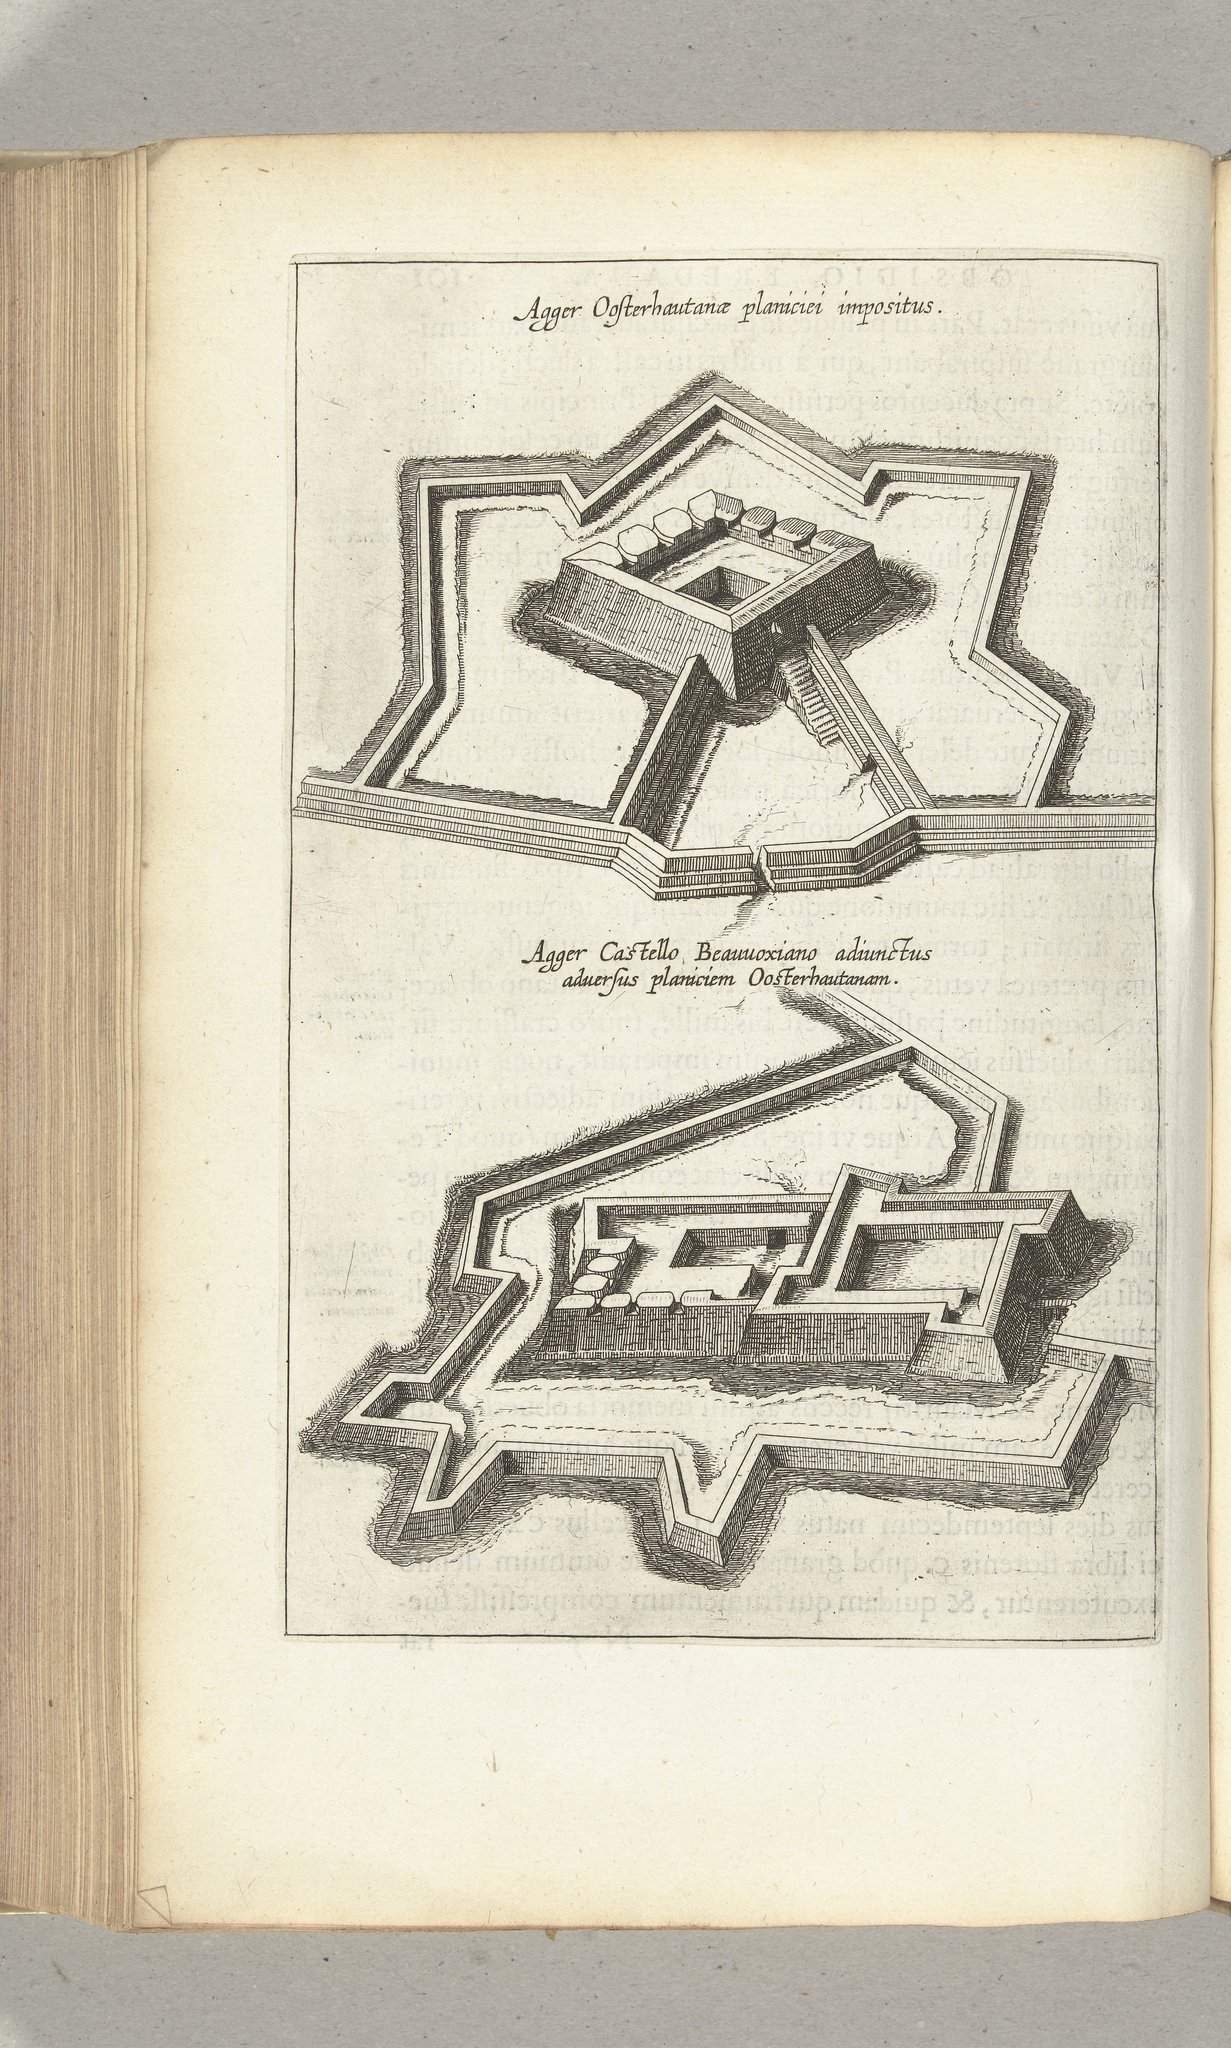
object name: print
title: Twee typen Spaanse bolwerken, 1624-1625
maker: Anonymous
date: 1625-1626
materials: paper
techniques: engraving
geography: southern netherlands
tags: fortifications, military engineering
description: Illustratie in: Hermannus Hugo, Obsidio Bredana armis Philippi IIII avspiciis Isabellae Dvctv Ambr. Spinolae perfecta, ex off. Plantiniana, Antwerpen 1629, p. 102/103. Exemplaar in de collectie van de Rijksmuseum Research Library met signatuur 327 I 25. In M. Funck, Le livre belge à gravures : guide de l'amateur de livres illustrés imprimés en Belgique avant le XVIIIe siècle (1925) worden deze illustraties toegeschreven aan Theodoor Galle (11) en Schelte en Boëtius Bolswert (4). Ze worden echter in Hollstein niet bij deze prentmakers vermeld.